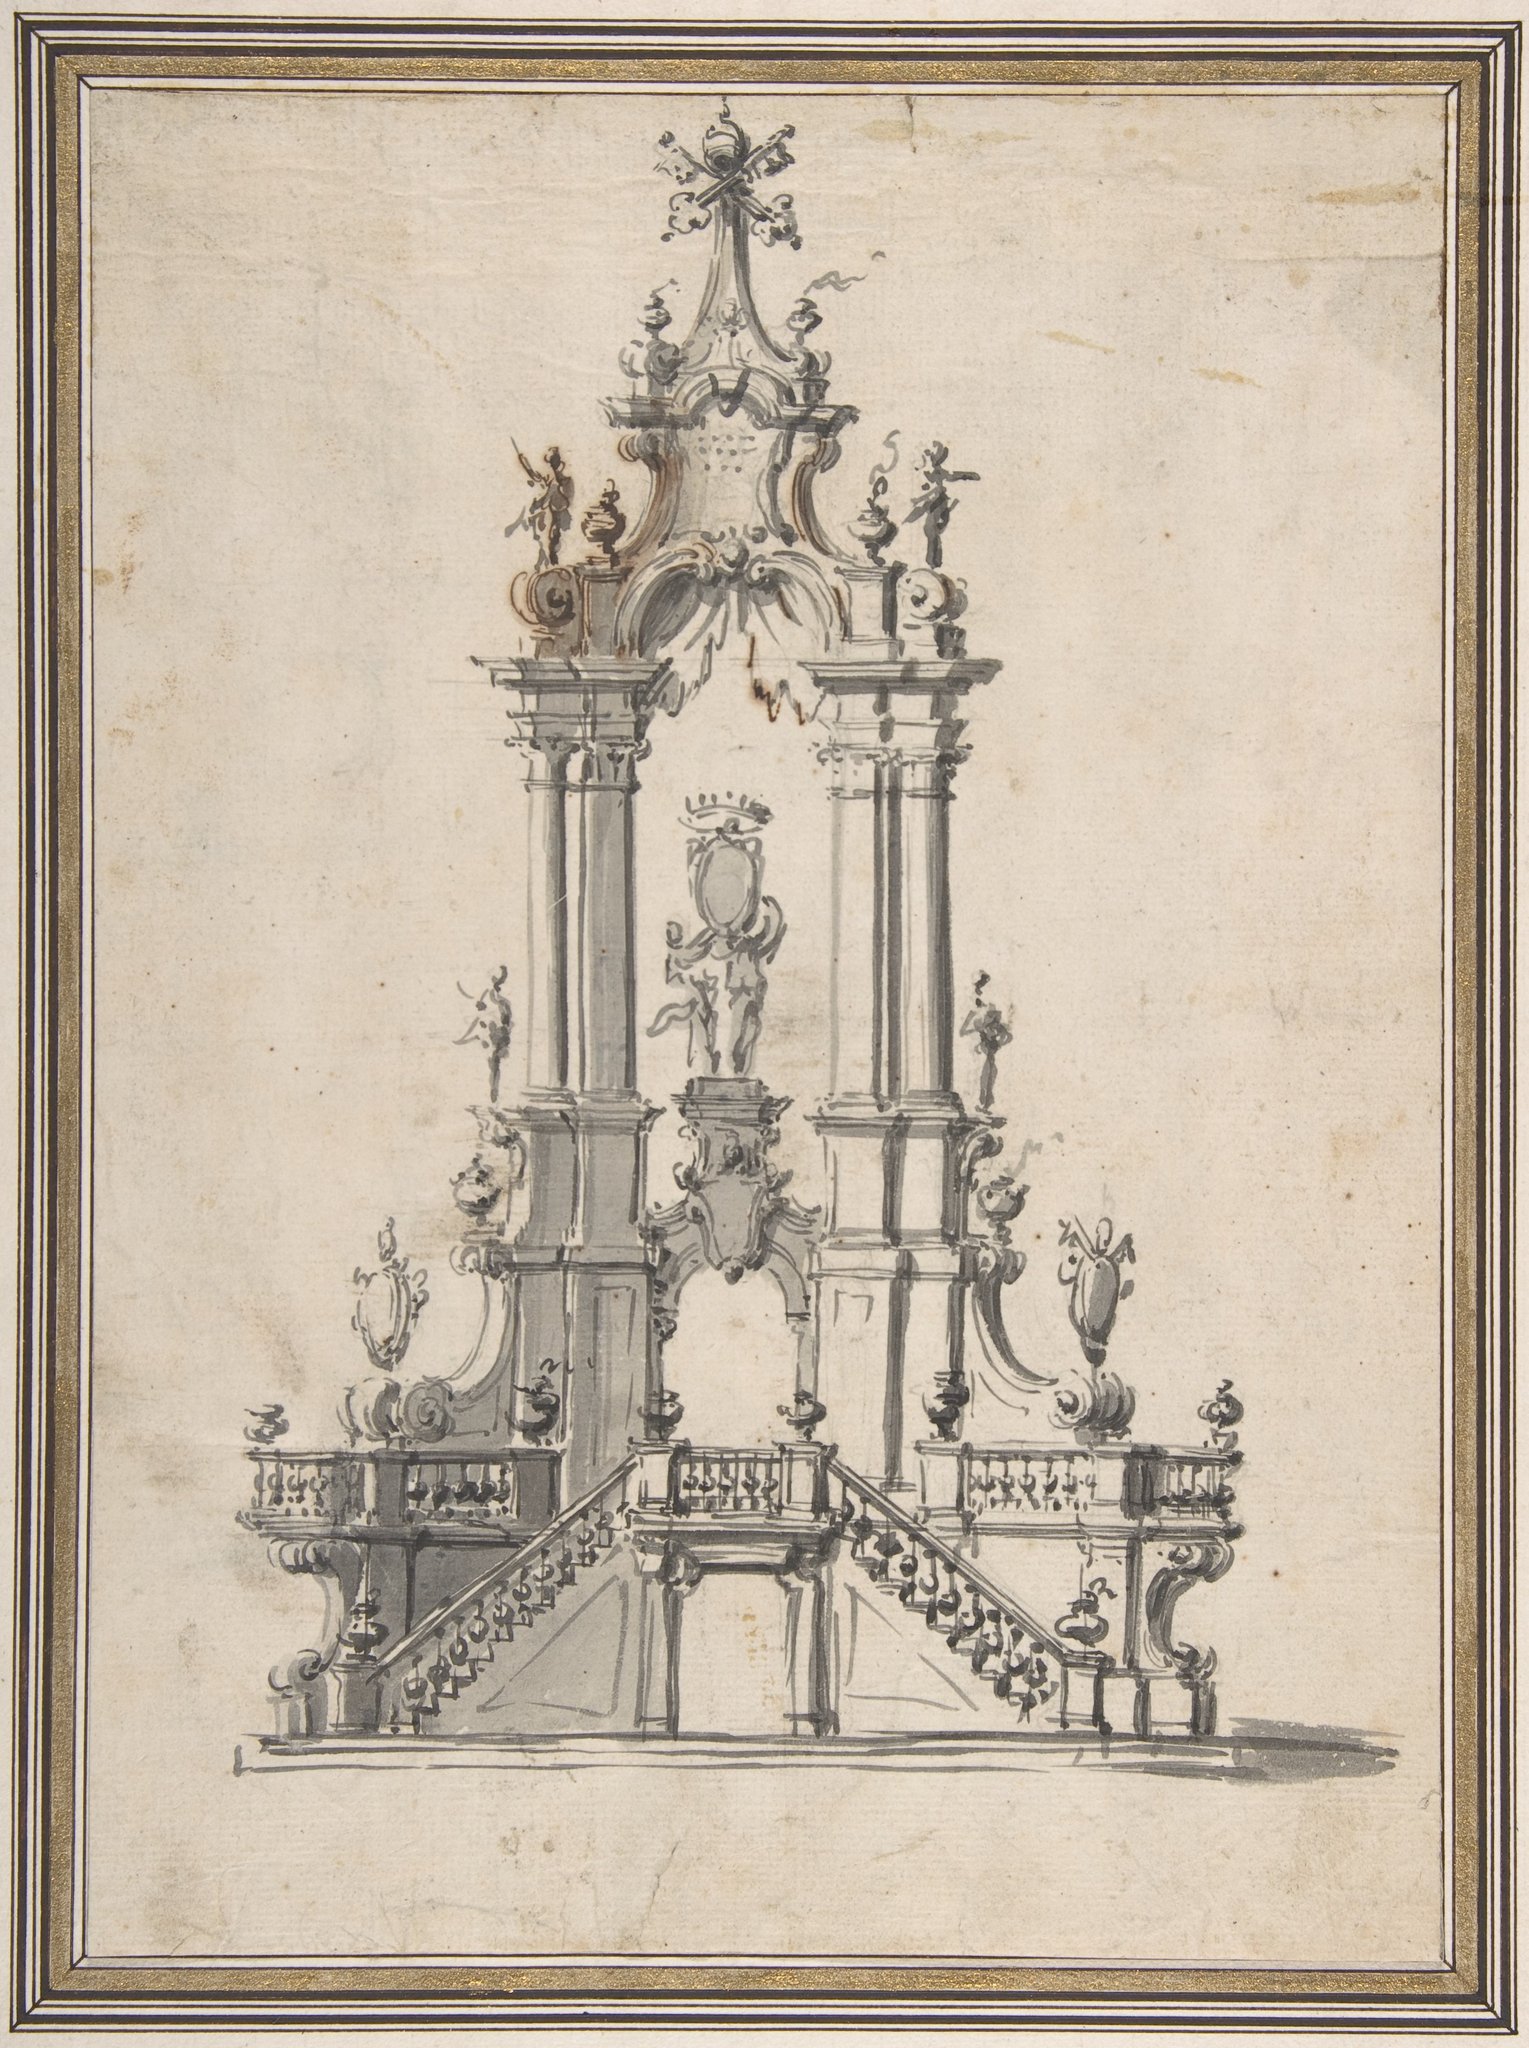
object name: drawing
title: Design for a Catafalque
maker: anonymous, italian, 18th century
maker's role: artist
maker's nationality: italian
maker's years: 1700-1800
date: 1701-1800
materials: ink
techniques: wash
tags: architecture